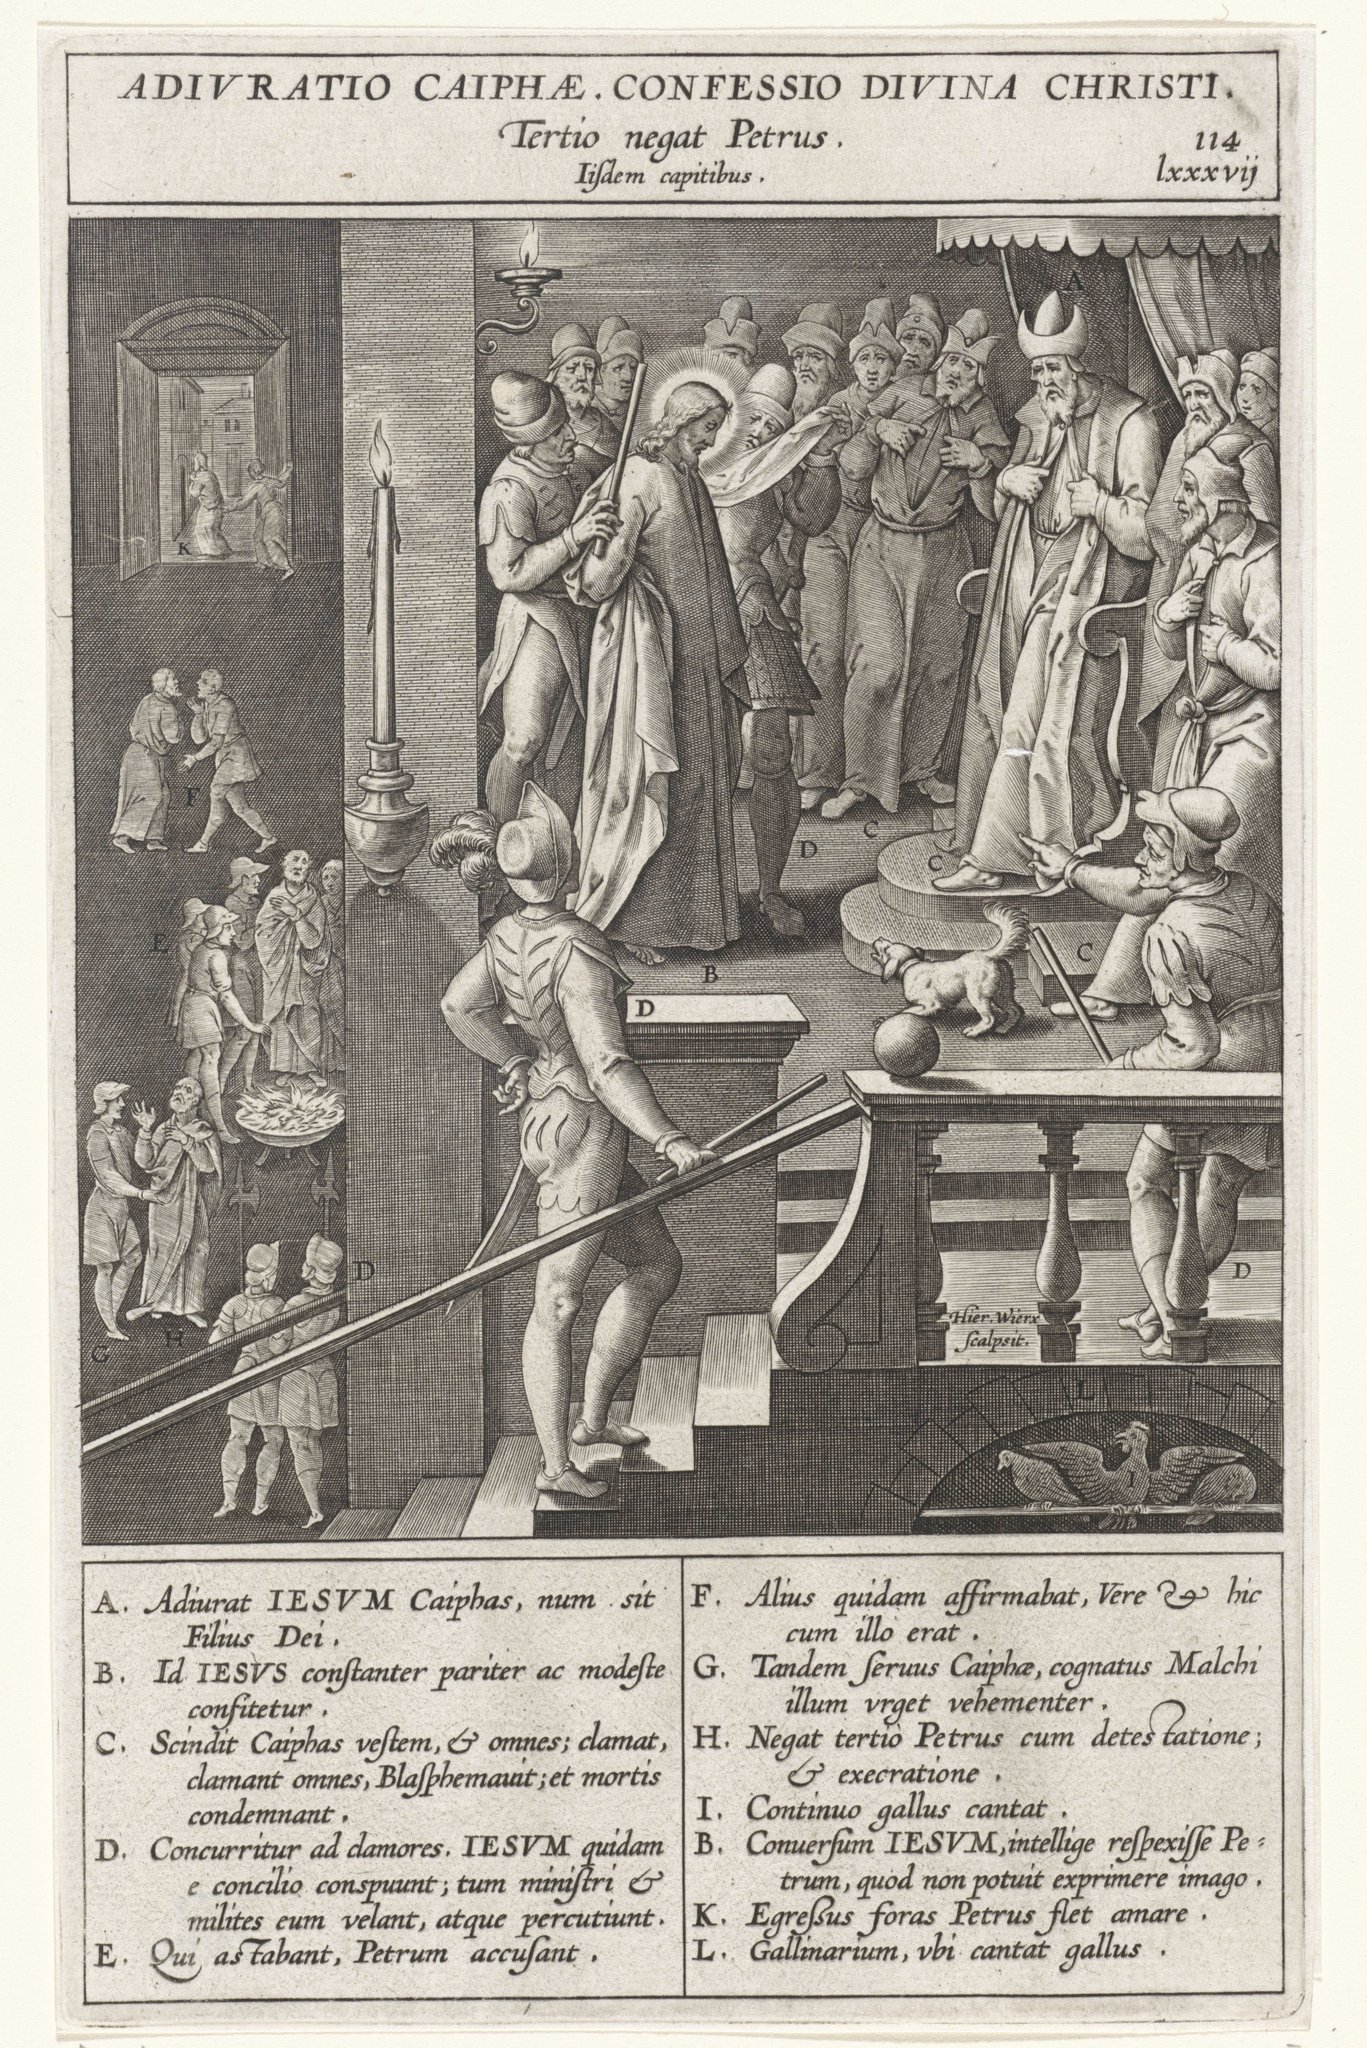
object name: print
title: Christus voor Kajafas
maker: hieronymus wierix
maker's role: draughtsman, print maker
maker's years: 1553-1619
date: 1593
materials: paper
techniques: engraving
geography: antwerp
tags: caiaphas tearing his clothes ~ trial of christ, peter denies christ, usually before a girl-servant and some soldiers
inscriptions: collector's mark: Lugt 2165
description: Christus wordt berecht door Kajafas. De hogepriester scheurt zijn gewaad en beschuldigt Christus van godslastering. Bij verschillende elementen uit de voorstelling staan letters die corresponderen met de legenda in de marge.